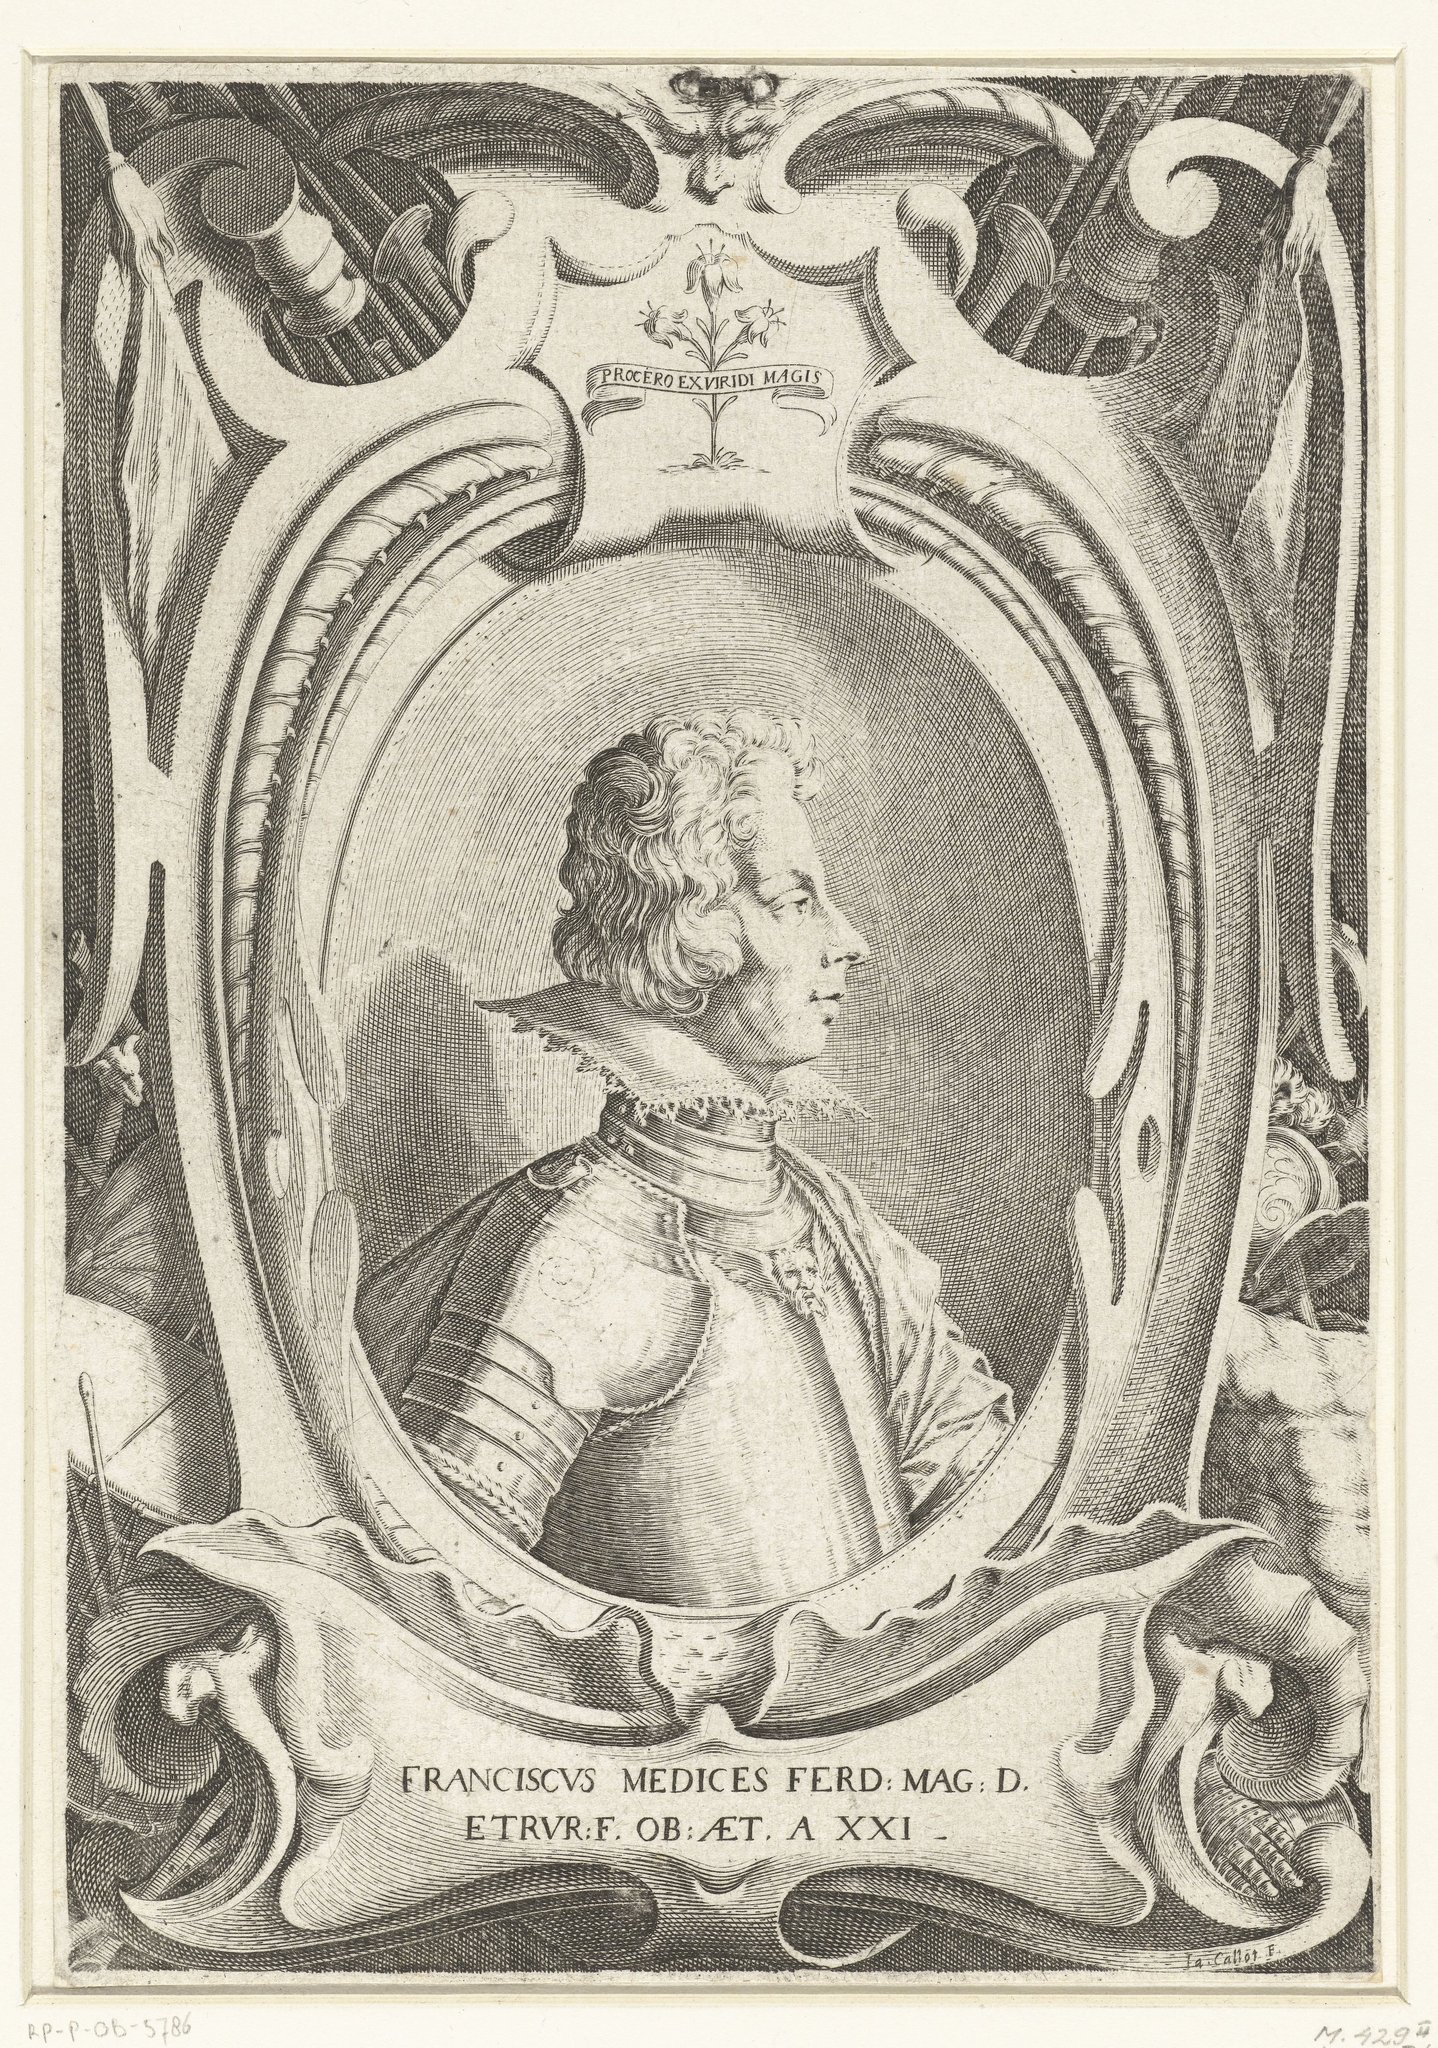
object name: print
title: Portret van Francesco II de' Medici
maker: jacques callot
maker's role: draughtsman, print maker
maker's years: 1592-1635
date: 1614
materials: paper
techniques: engraving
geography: florence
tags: armour, historical persons, weapons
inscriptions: collector's mark: Lugt 240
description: Gebruikt als illustratie in: Vieri Cerchi, 'Delle lodi di Don Francesco Medici de' principi de Toscana' (Florence: Cosimo Giunti, 1614) of Alessandro ldimari, 'Esequie dell' Illustrissimo & eccelentissimo principe don Francesco Medici' (Florence: Giovanni Donato en Bernardino Giunti, 1614). Klinkert, C.